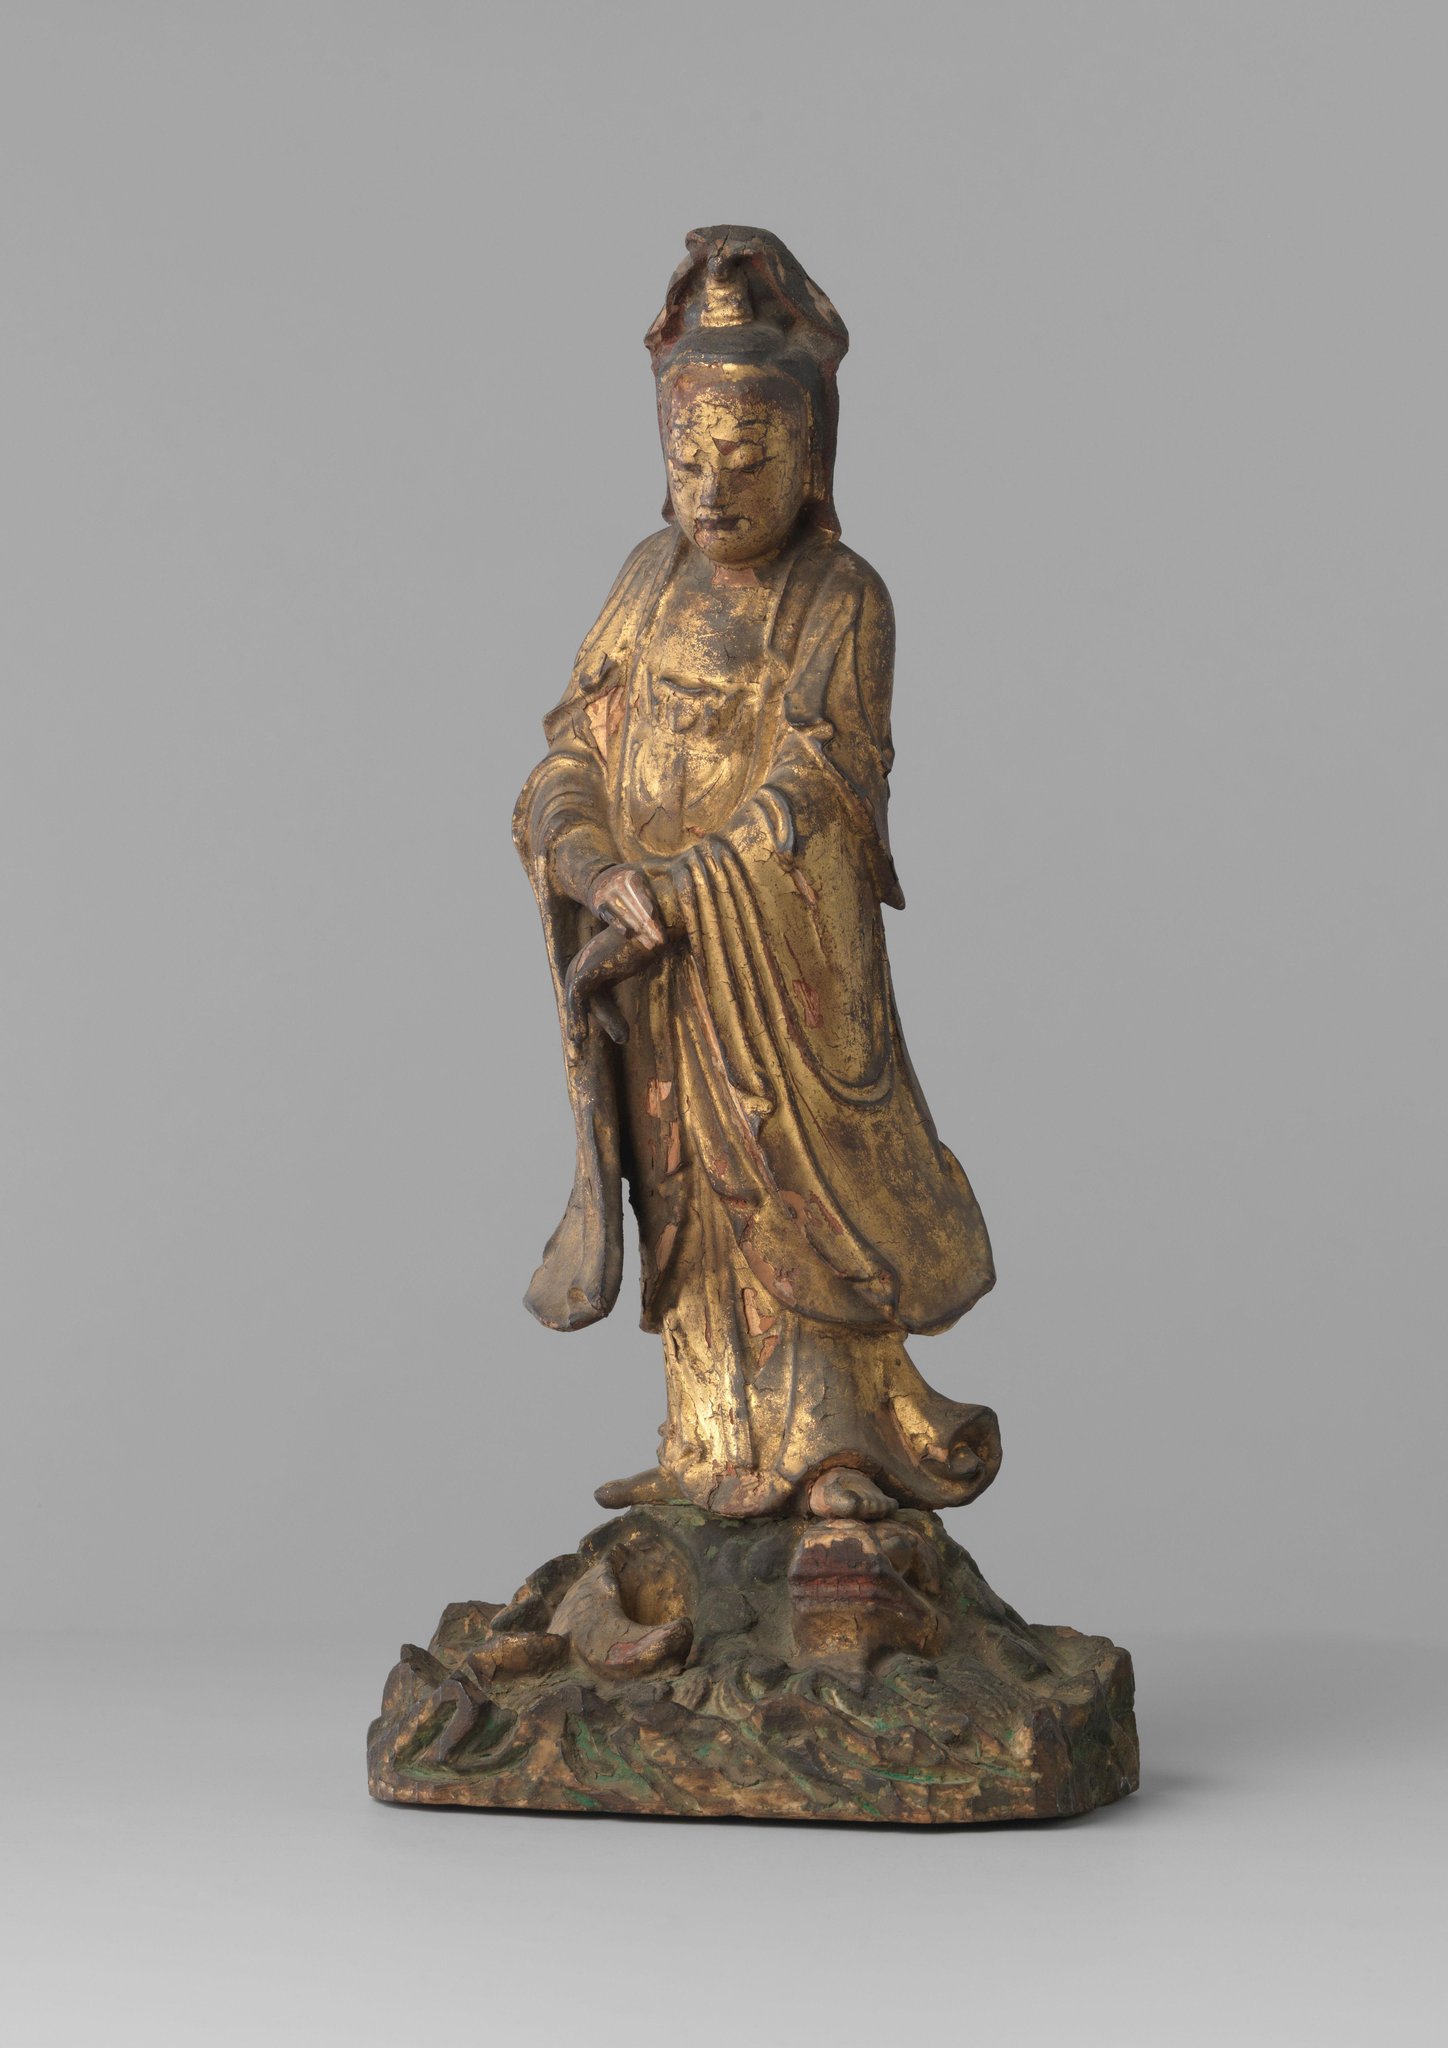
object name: avalokitesvara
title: Guanyin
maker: Anonymous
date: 1368-1644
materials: wood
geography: china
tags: guan yin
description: Guanyin stands on a dragon fish in order to be carried across the sea. Buddhist texts describe Buddha's body as being gold. Accordingly, sculptures of buddhas and bodhisattvas are usually gold coloured, a reference to their holiness.